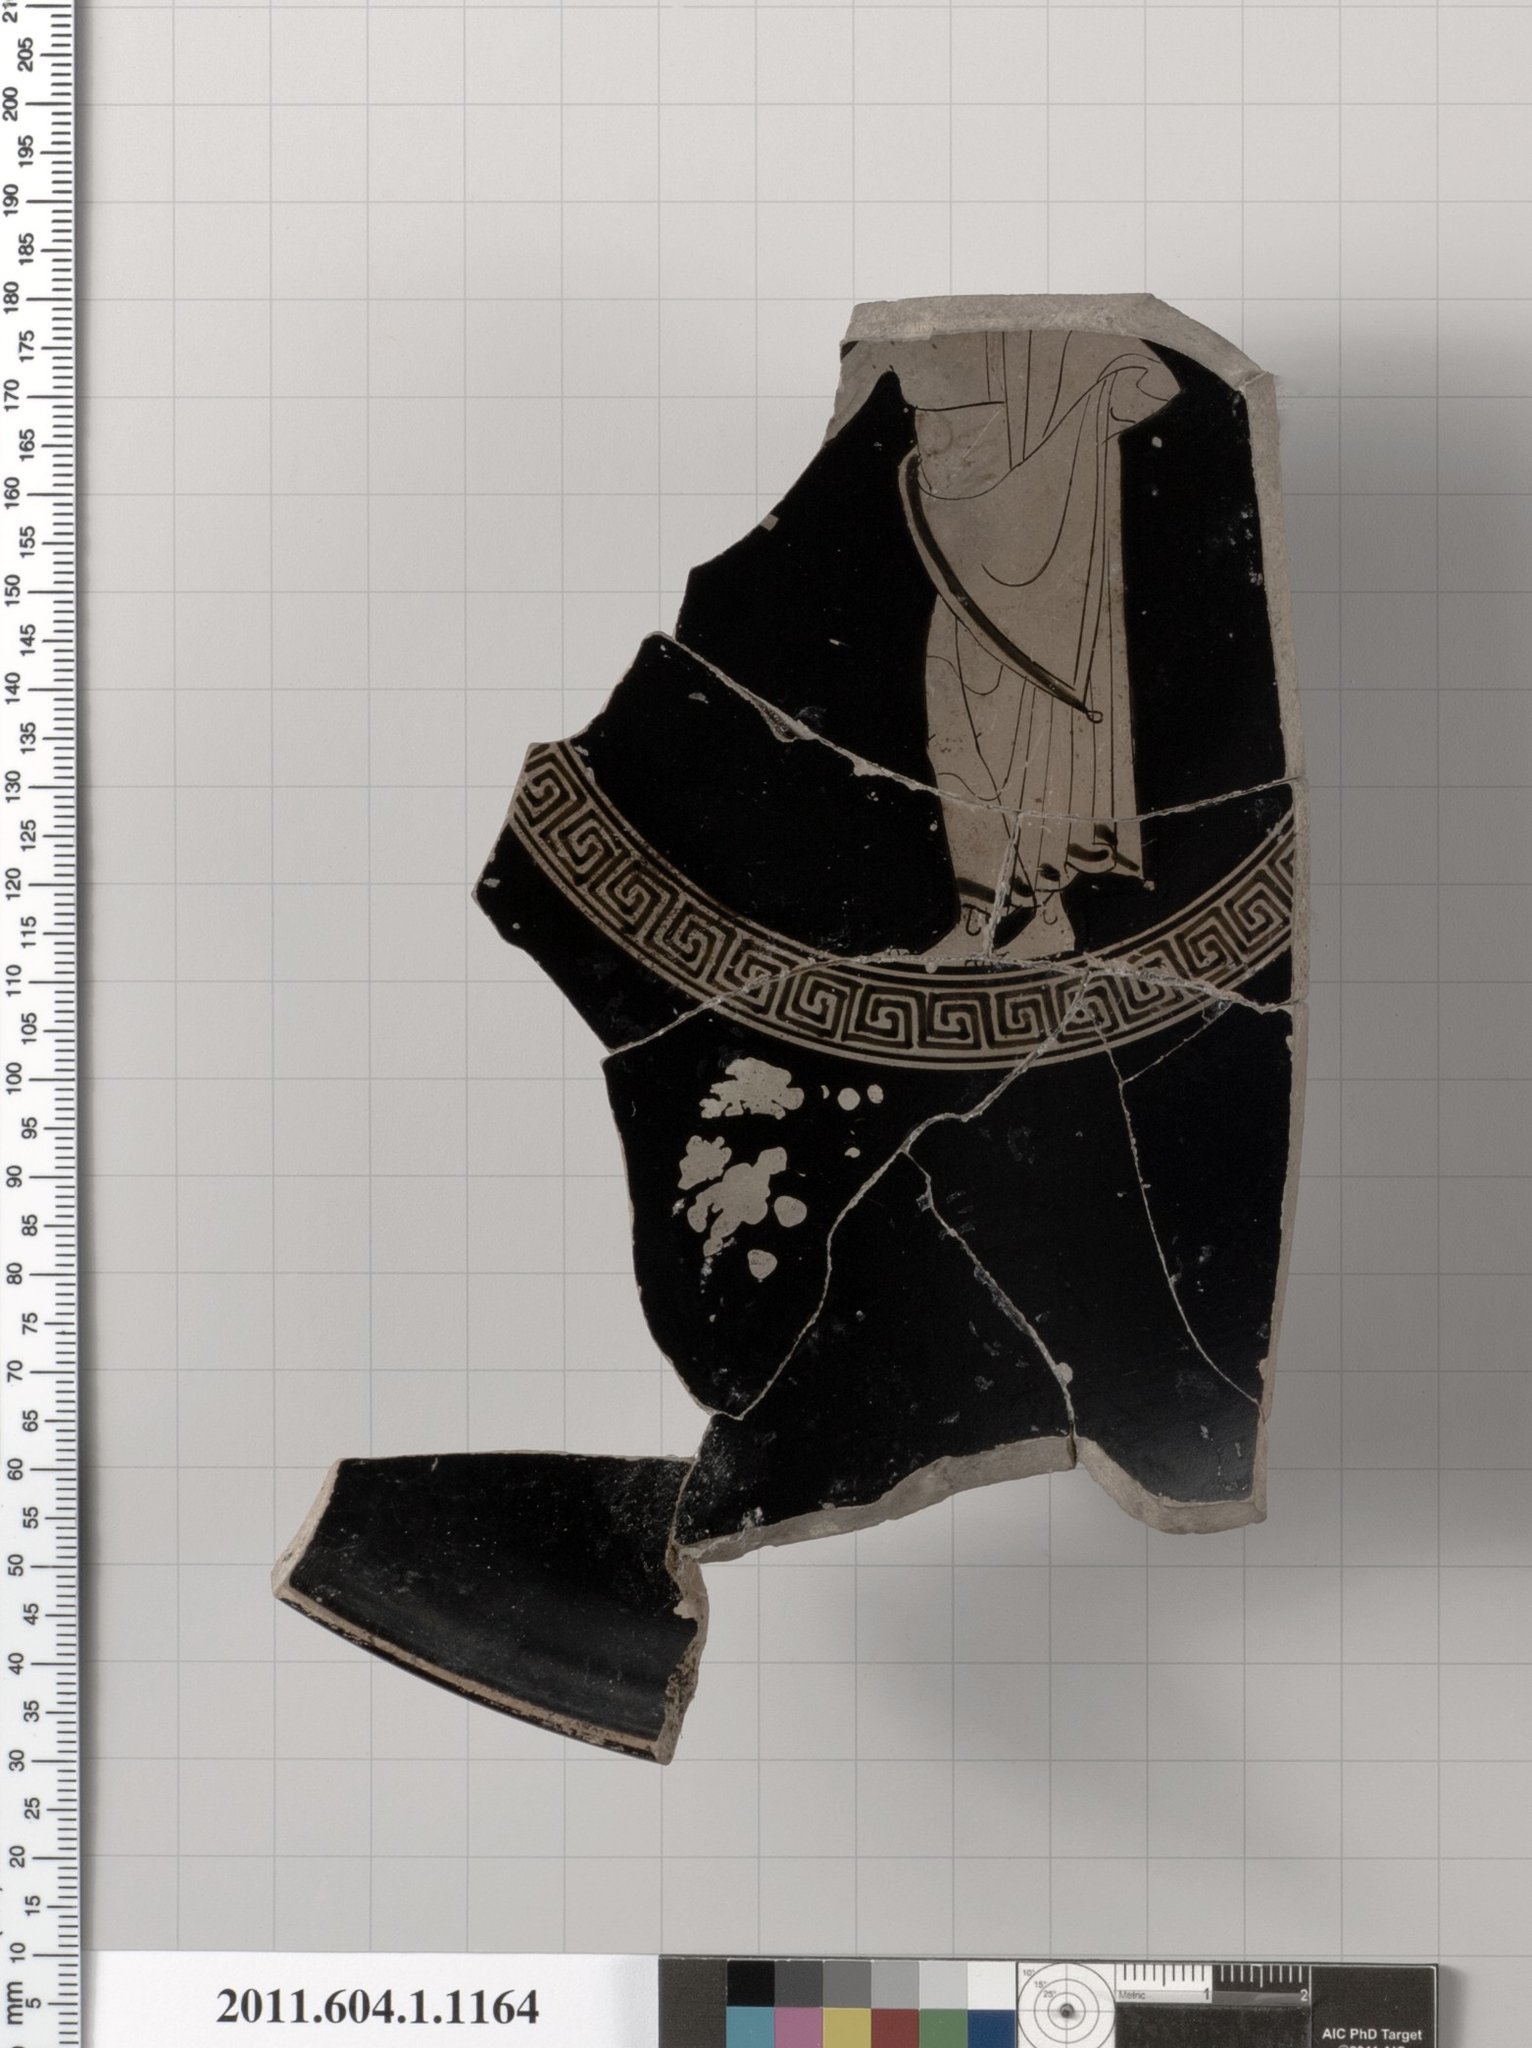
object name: kylix fragment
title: Terracotta fragment of a kylix (drinking cup)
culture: greek, attic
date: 490-480 BCE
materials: terracotta